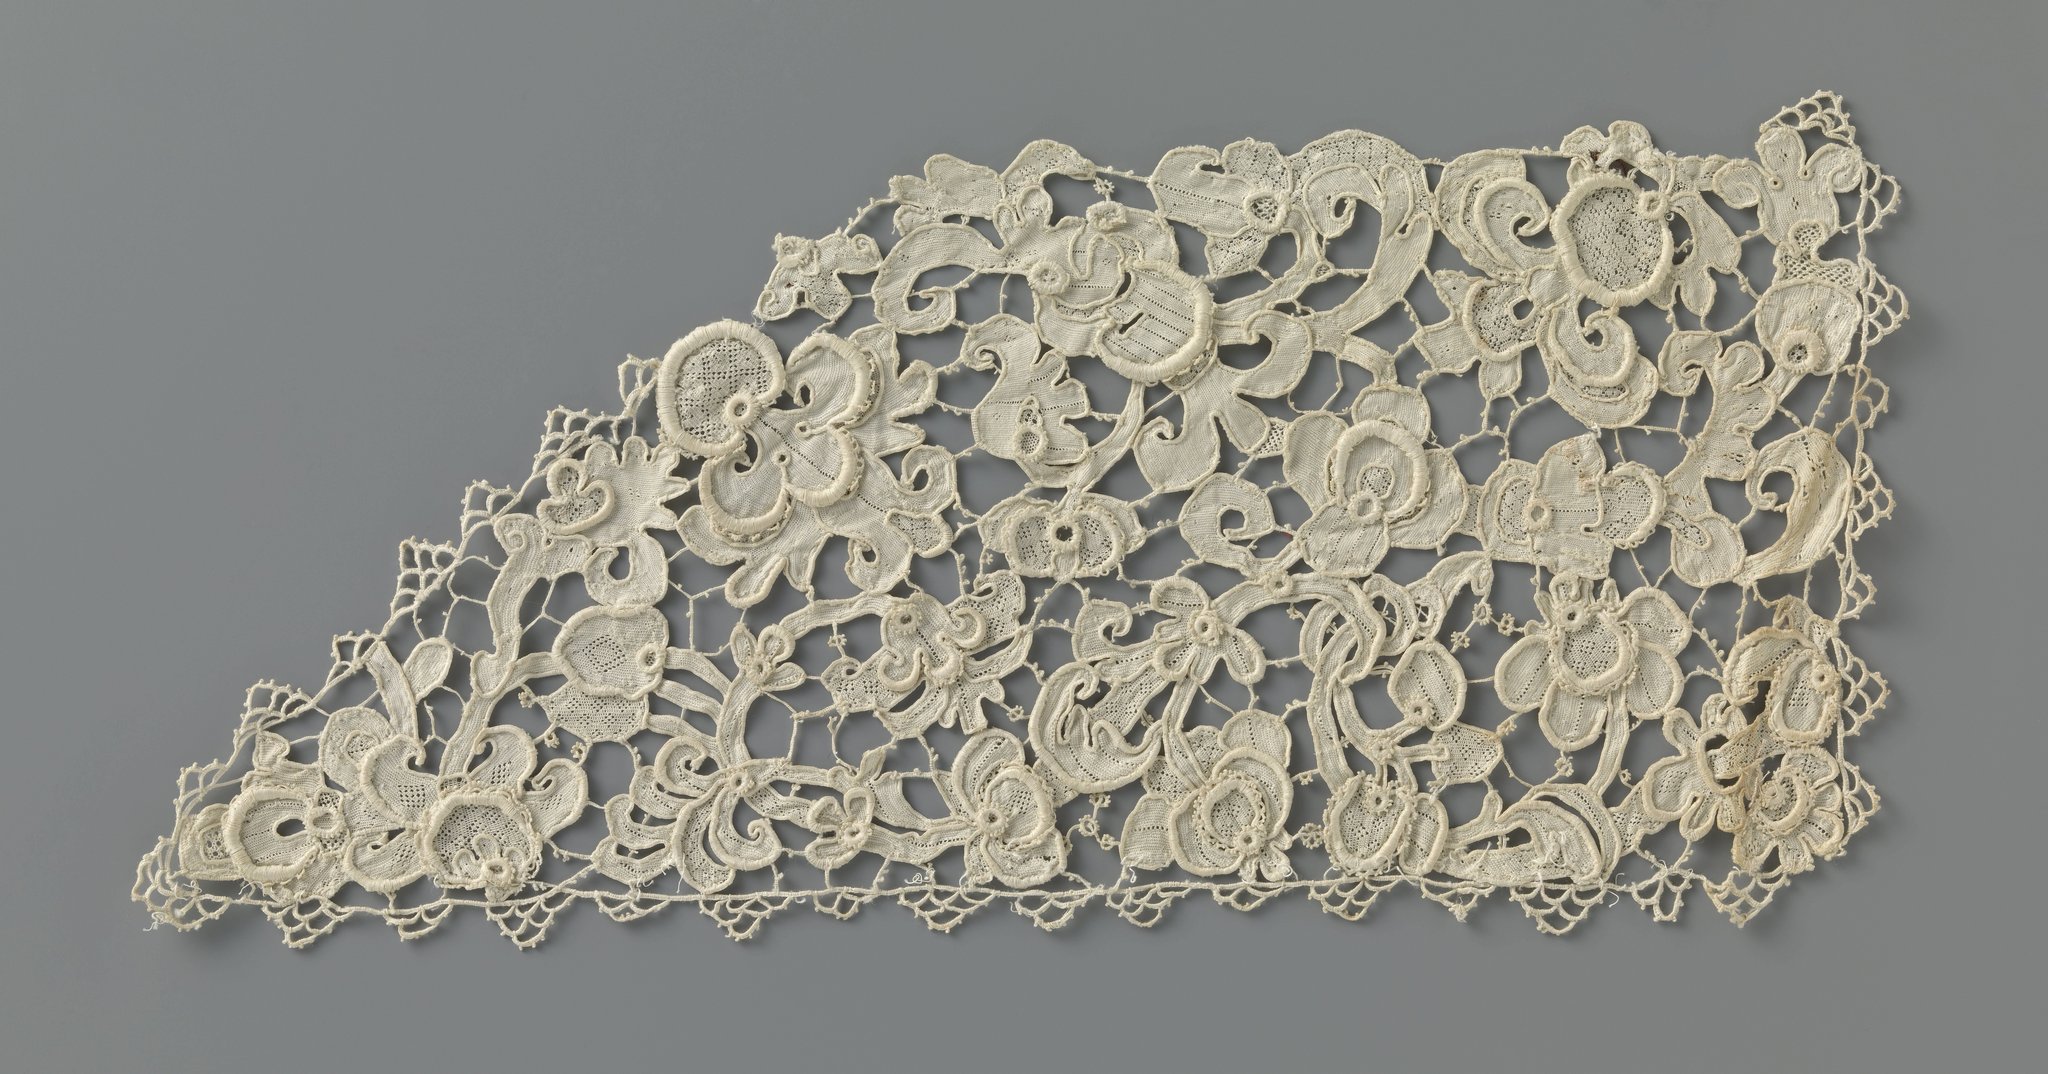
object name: band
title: Bef van naaldkant met arabeskenbladeren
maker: Anonymous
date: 1875-1909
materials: linen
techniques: embroidery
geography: burano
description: Bef van naturelkleurige naaldkant: Venetiaanse reliëfkant. Op een open spijlengrond staan zeer grote spiraalranken, onder andere hier en daar met een ring gesloten. Vlezige arabeskenbladeren en diverse bloemen vertonen een matig reliëf. Aan drie zijden loopt een (nieuw) boogjesrandje.